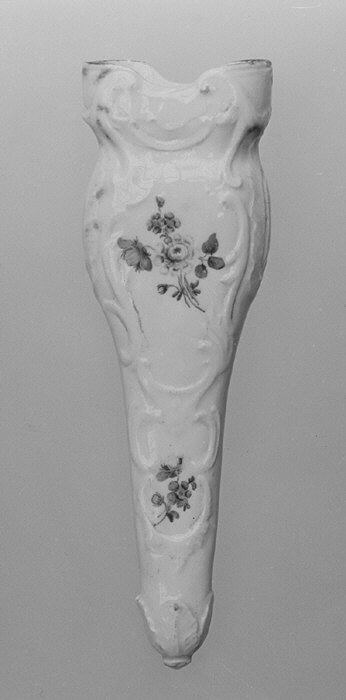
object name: bouquet holder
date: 1801-1900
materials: hard paste porcelain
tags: flowers